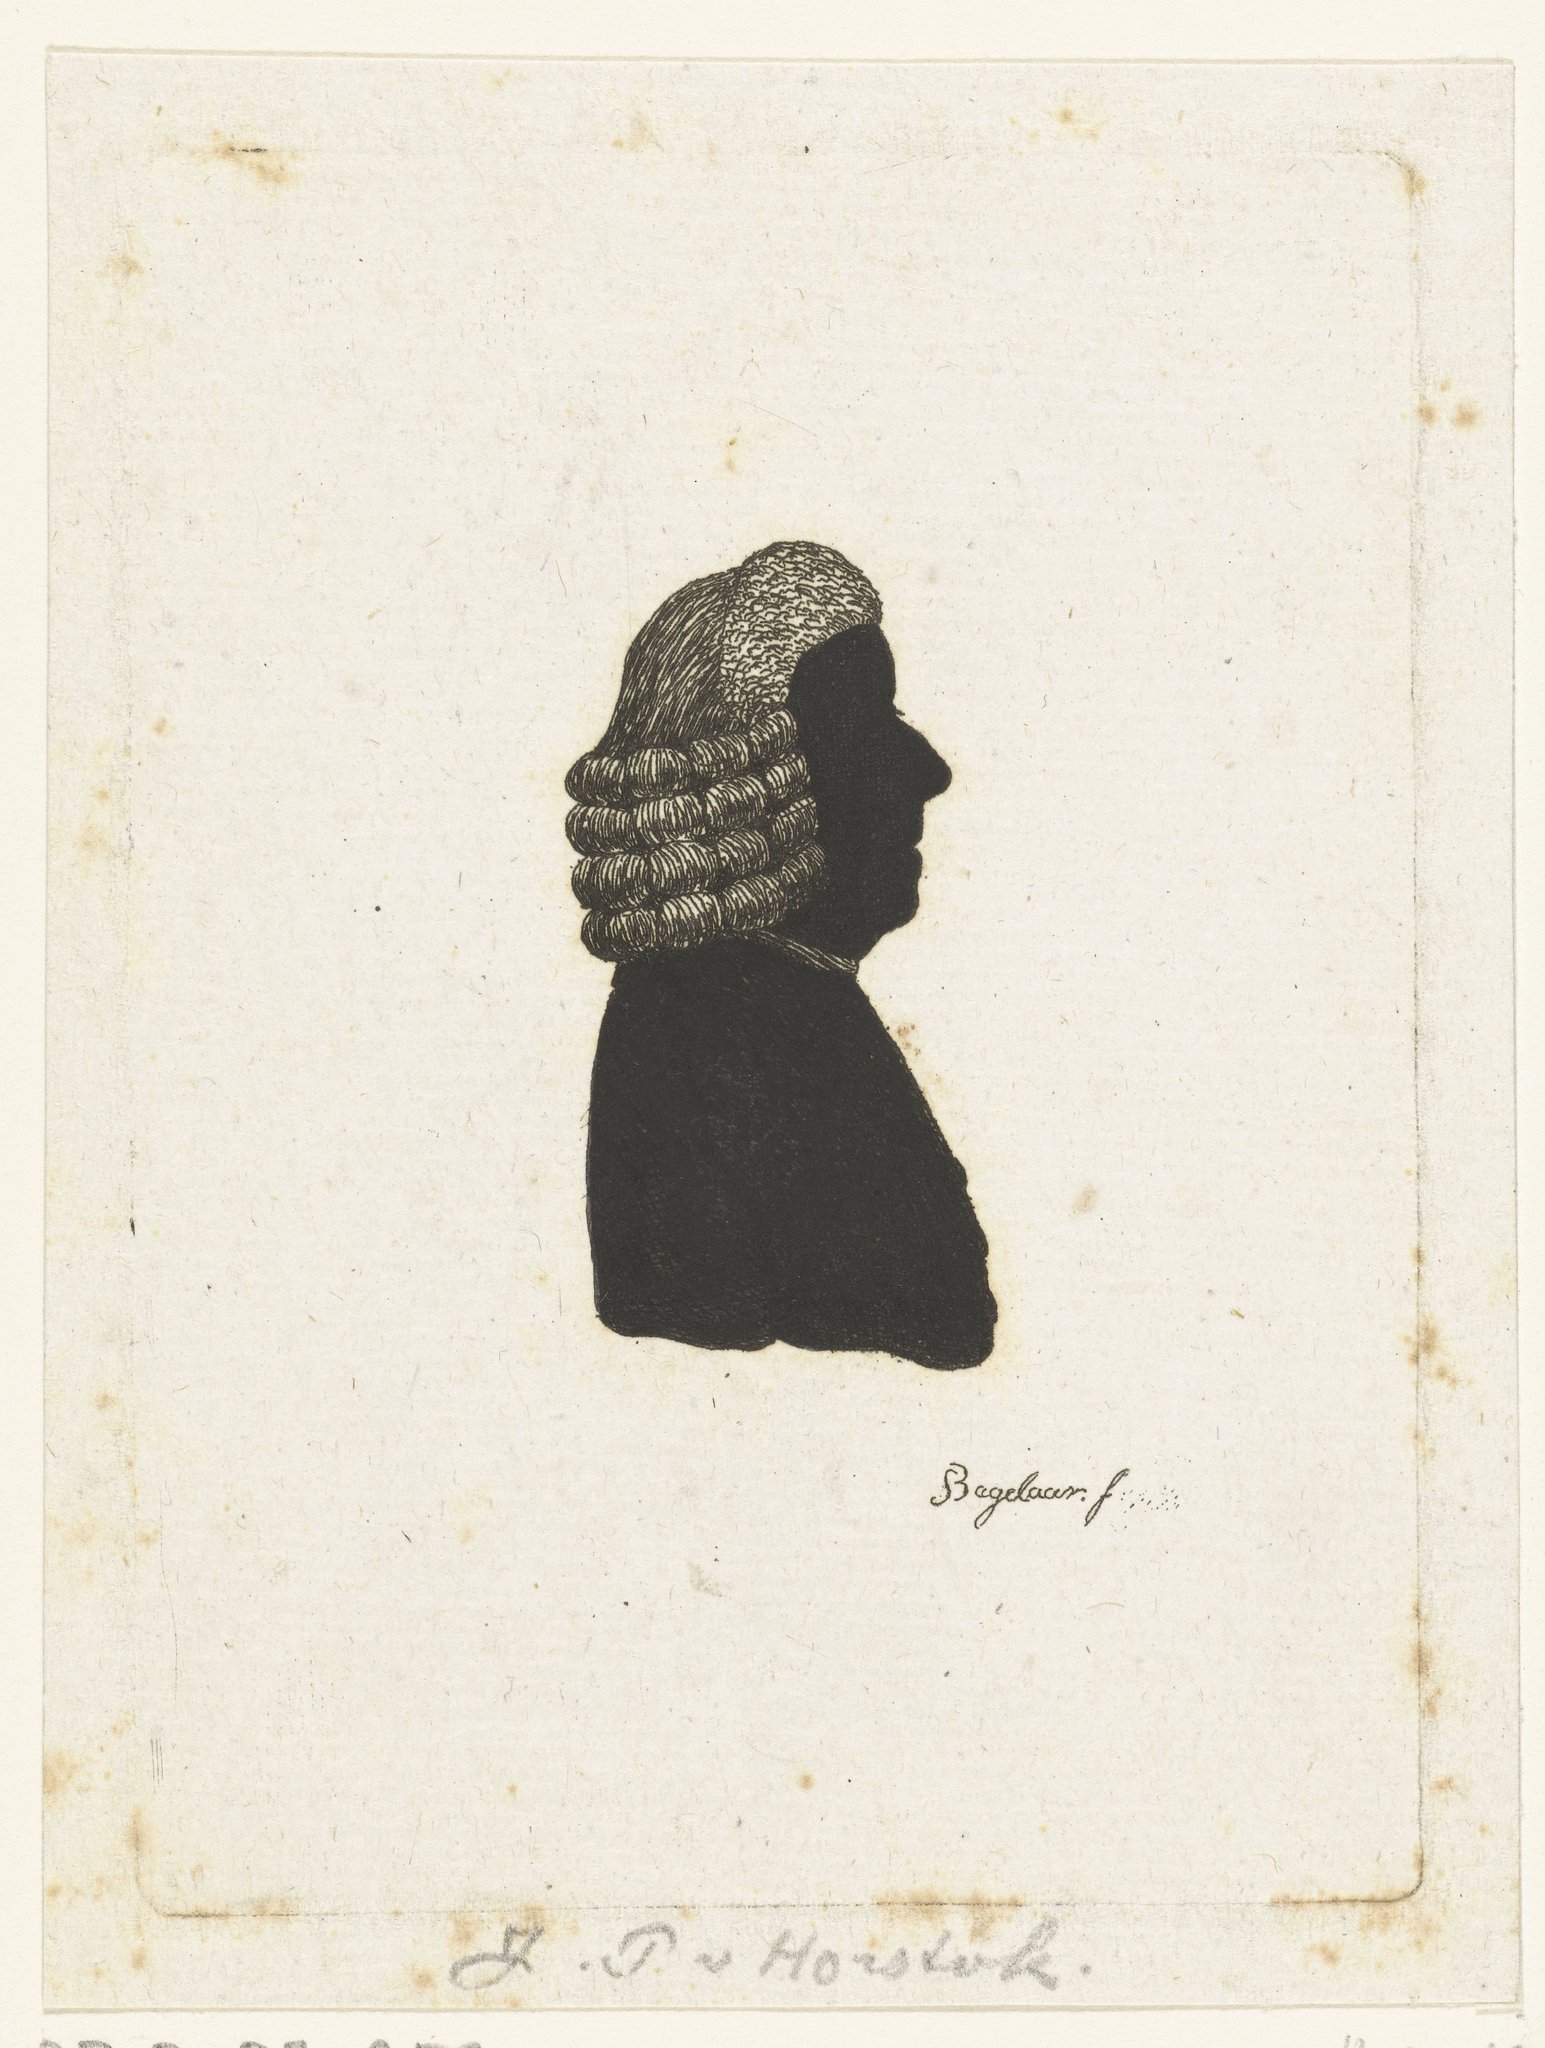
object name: print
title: Silhouetportret van Johannes Petrus van Horstok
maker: ernst willem jan bagelaar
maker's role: draughtsman, print maker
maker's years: 1775-1837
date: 1798-1837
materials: paper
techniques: etching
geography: netherlands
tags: painter, print maker, draughtsman, johannes petrus van horstok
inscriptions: collector's mark: Lugt 2228